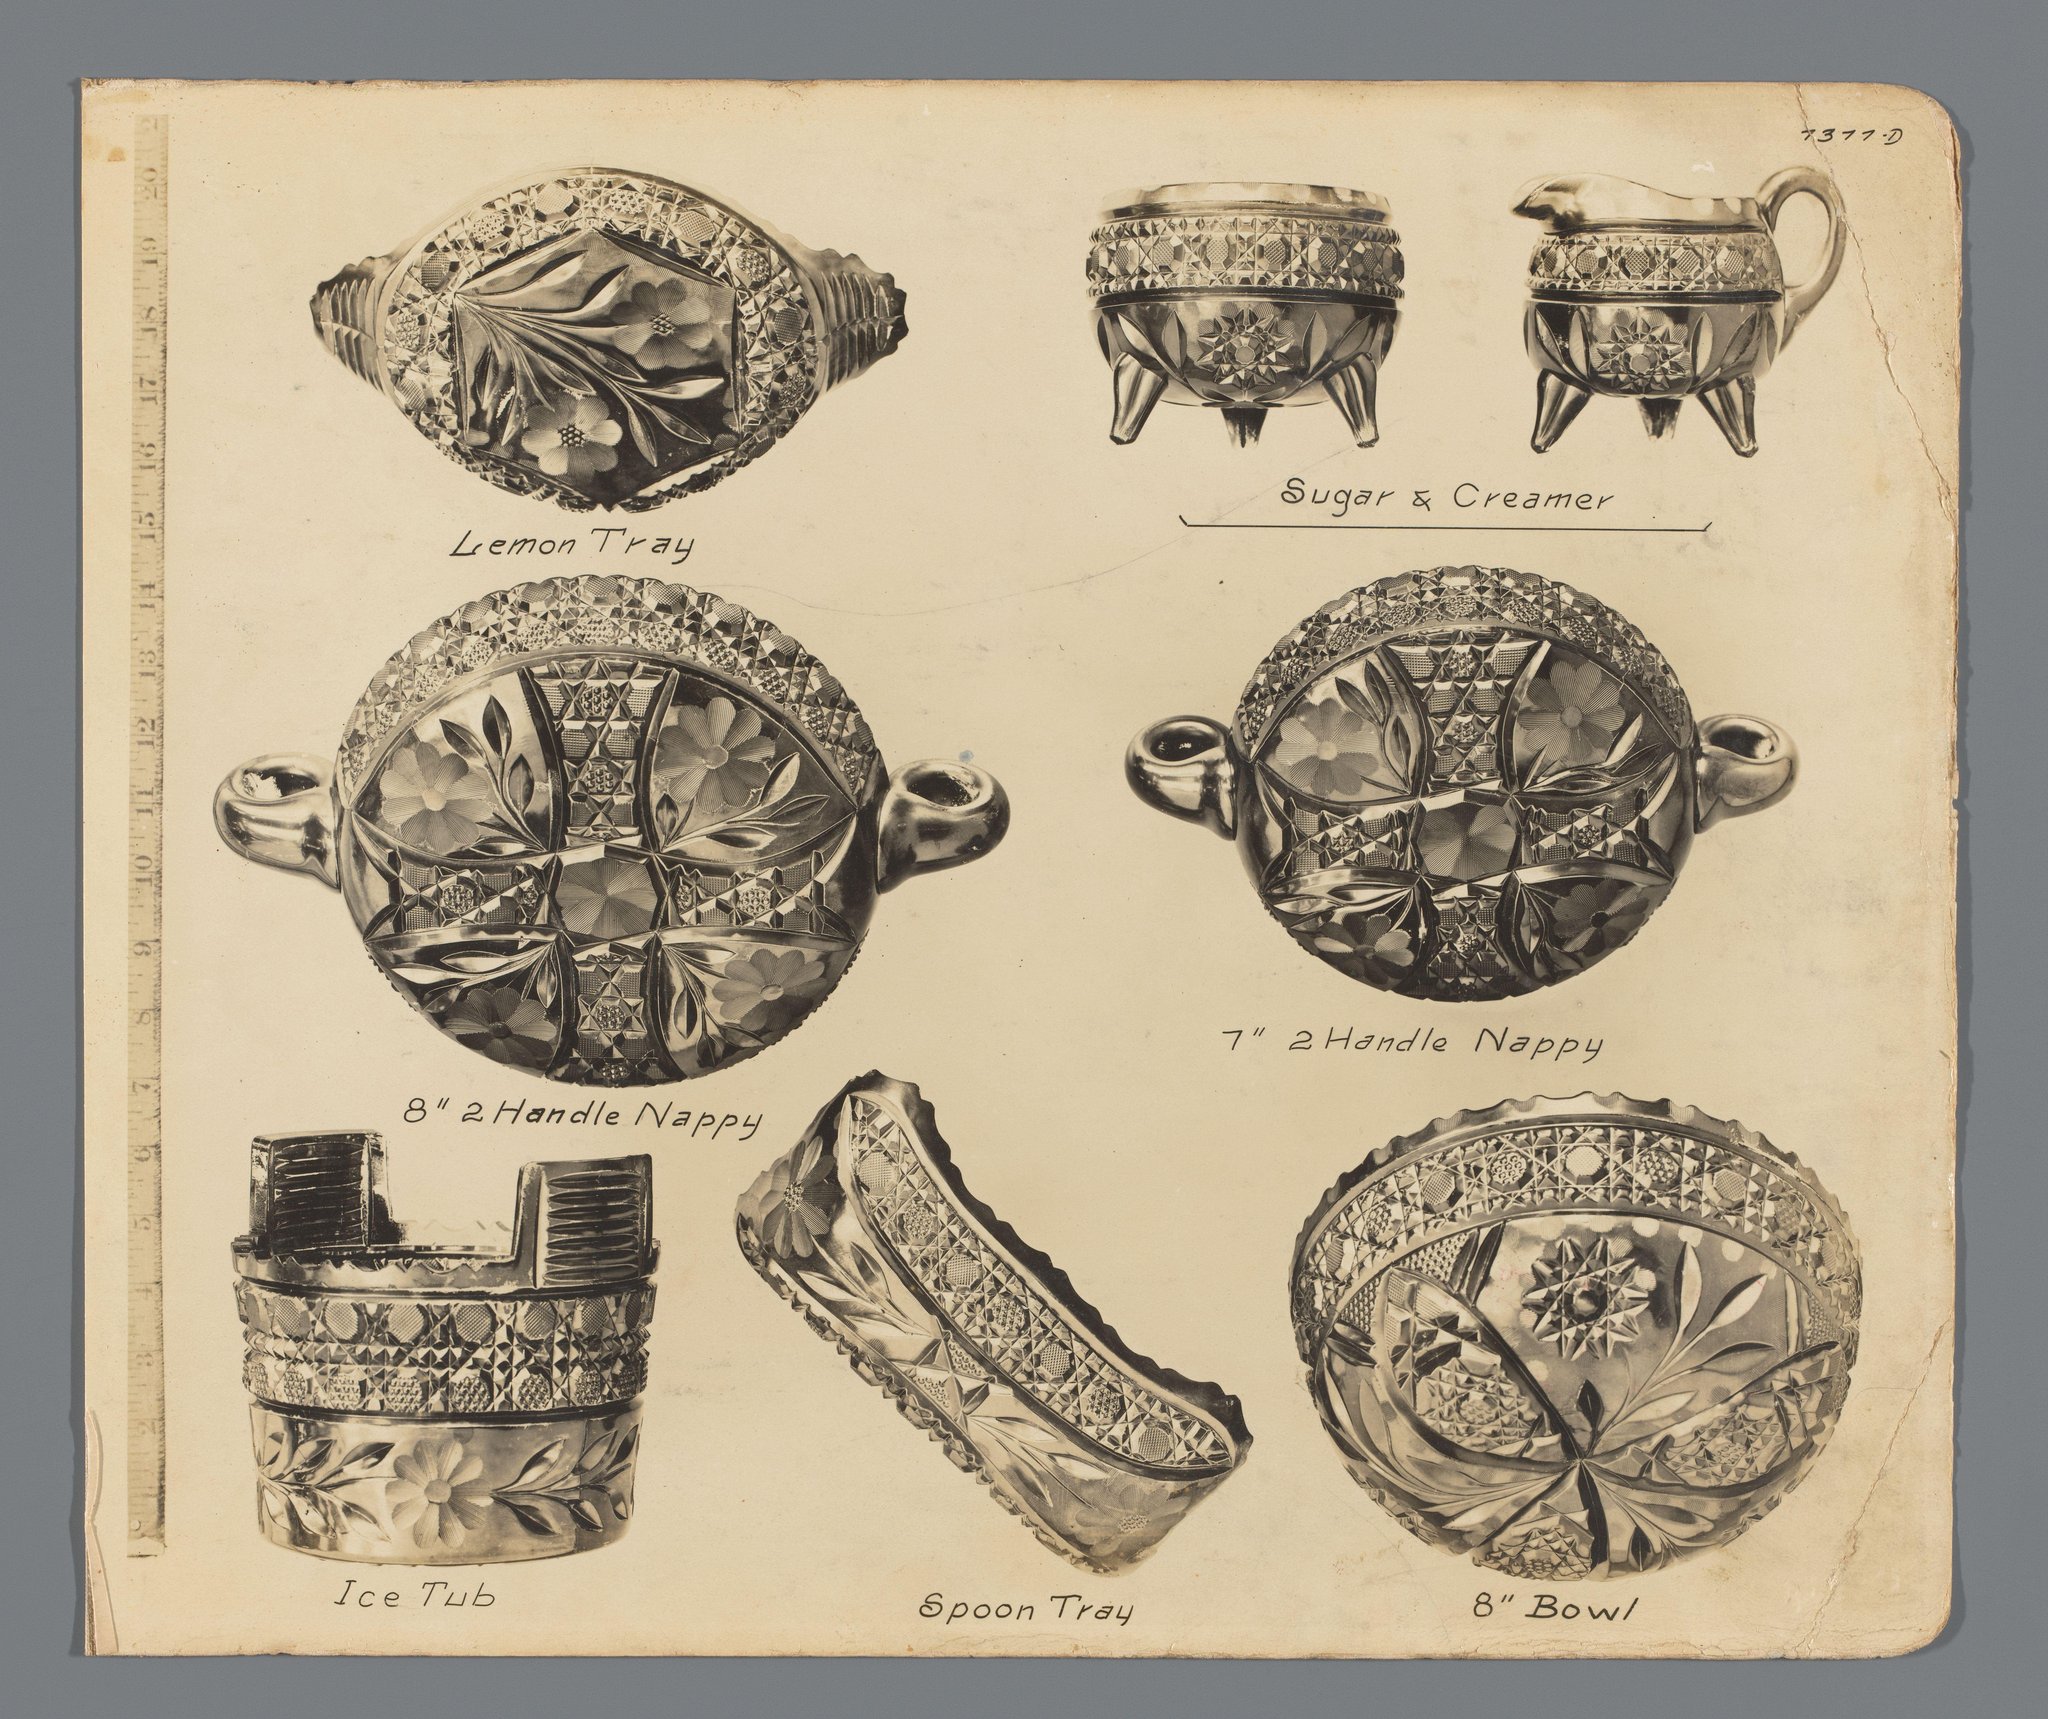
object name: photograph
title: Reclamefoto met serviezen en keukengerei van de firma C. Read & Co., Baltimore, Maryland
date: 1920-1930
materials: paper, textile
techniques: photography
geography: united states